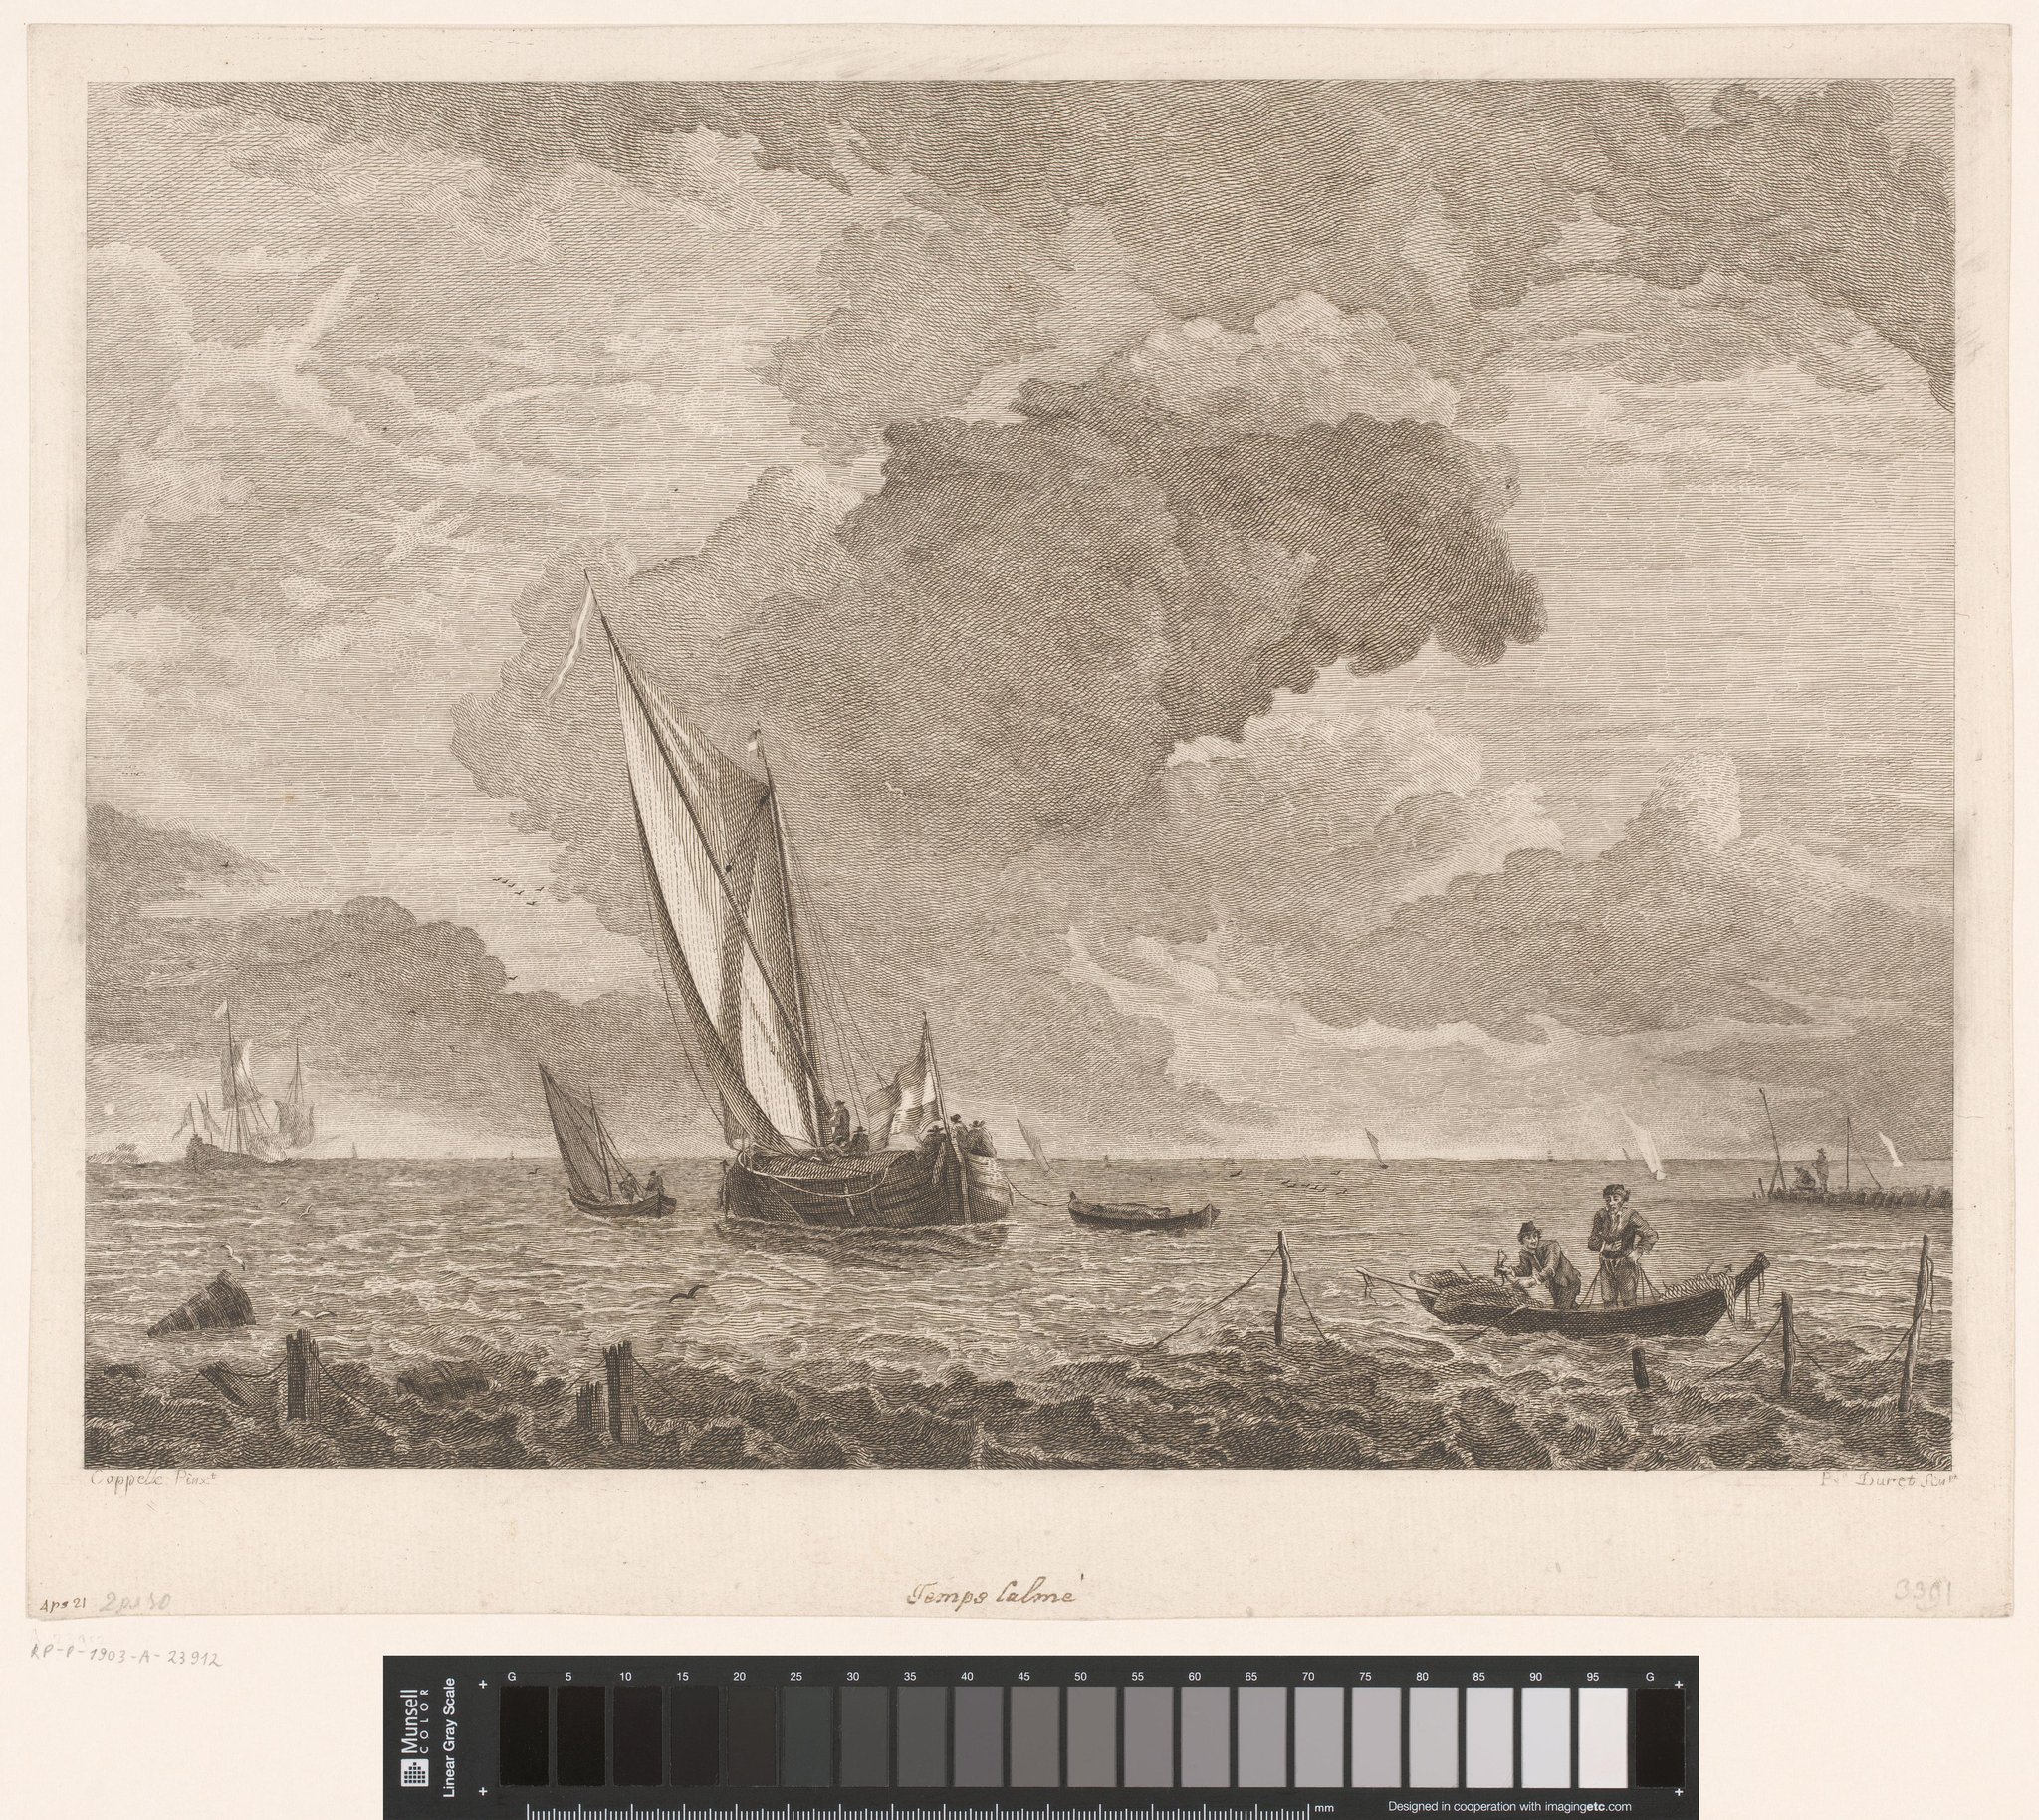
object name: print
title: Zeelandschap met boten en sloepen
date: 1739-1829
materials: paper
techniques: engraving, etching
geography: france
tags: sea (seascape)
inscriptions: title: ‘Temps calme’, watermark, collector's mark: Lugt 2228, inscription: ‘Aps [9?] 21’